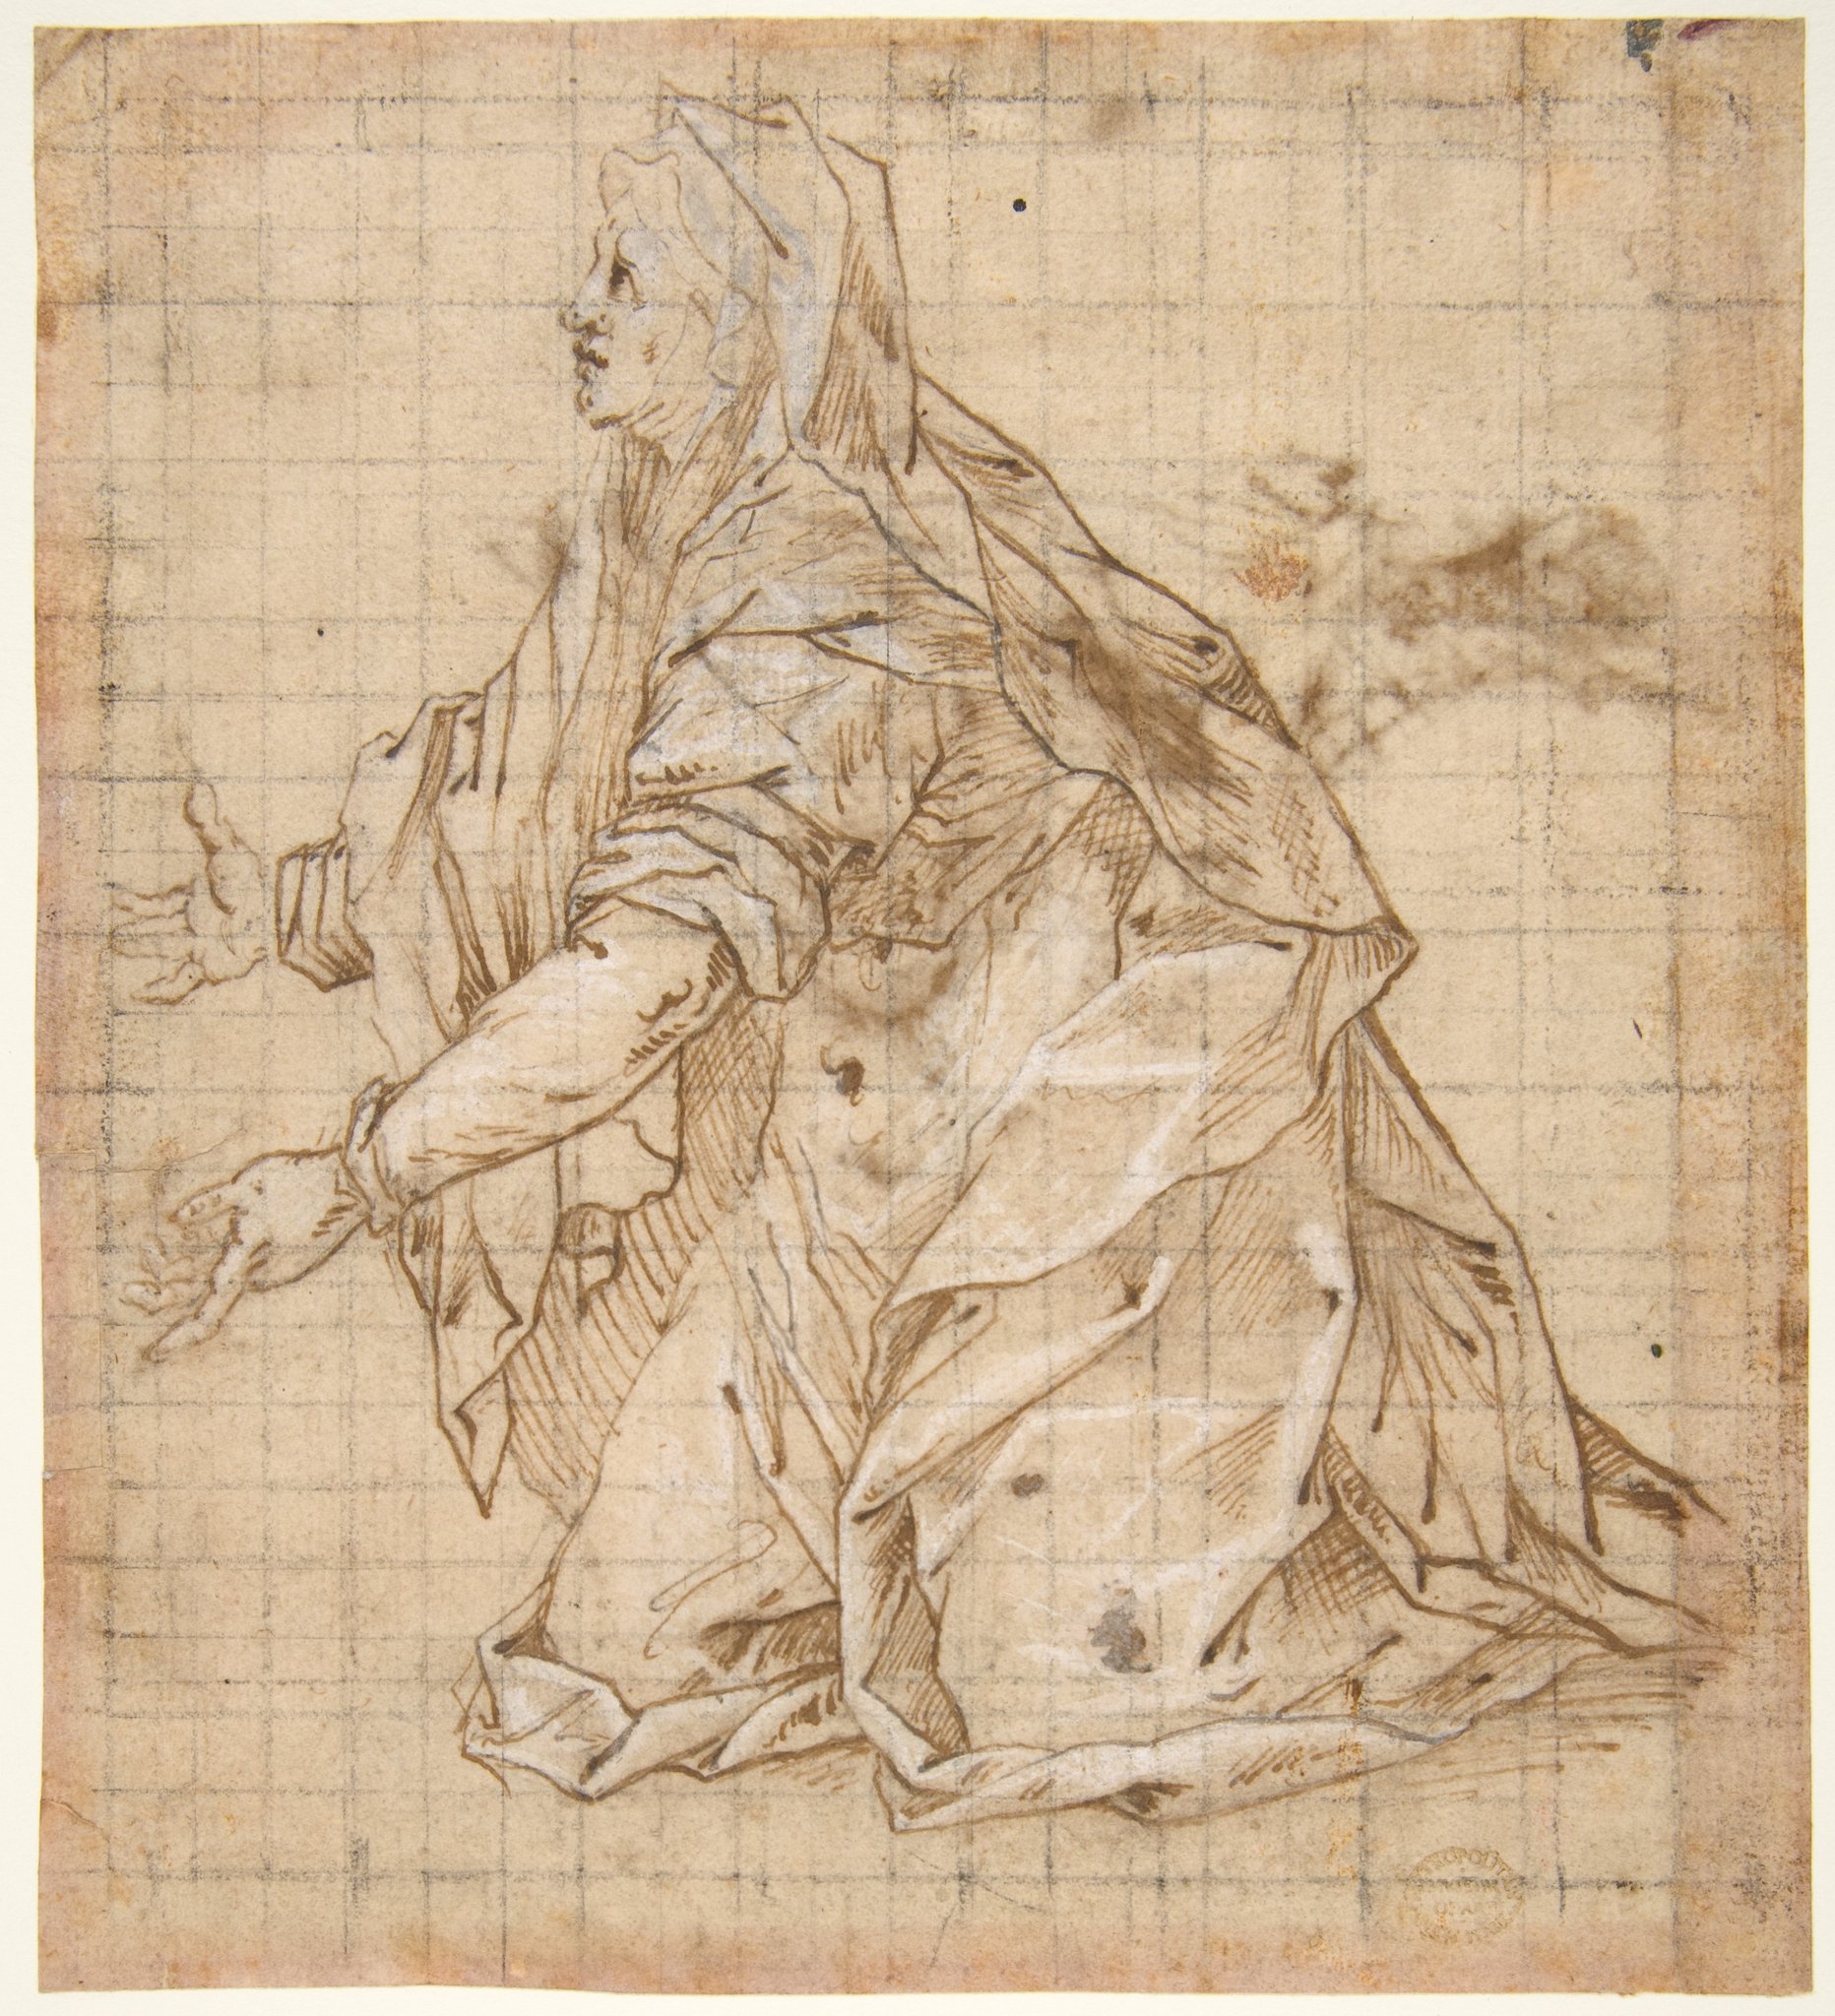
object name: drawing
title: Woman Kneeling Facing Left (recto); Seated Woman Facing Right (verso)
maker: giovanni battista trotti ("il malosso")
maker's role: artist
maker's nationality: italian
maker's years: 1556-1619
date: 1555-1619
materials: chalk, ink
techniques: pen, drawing, transfer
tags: women